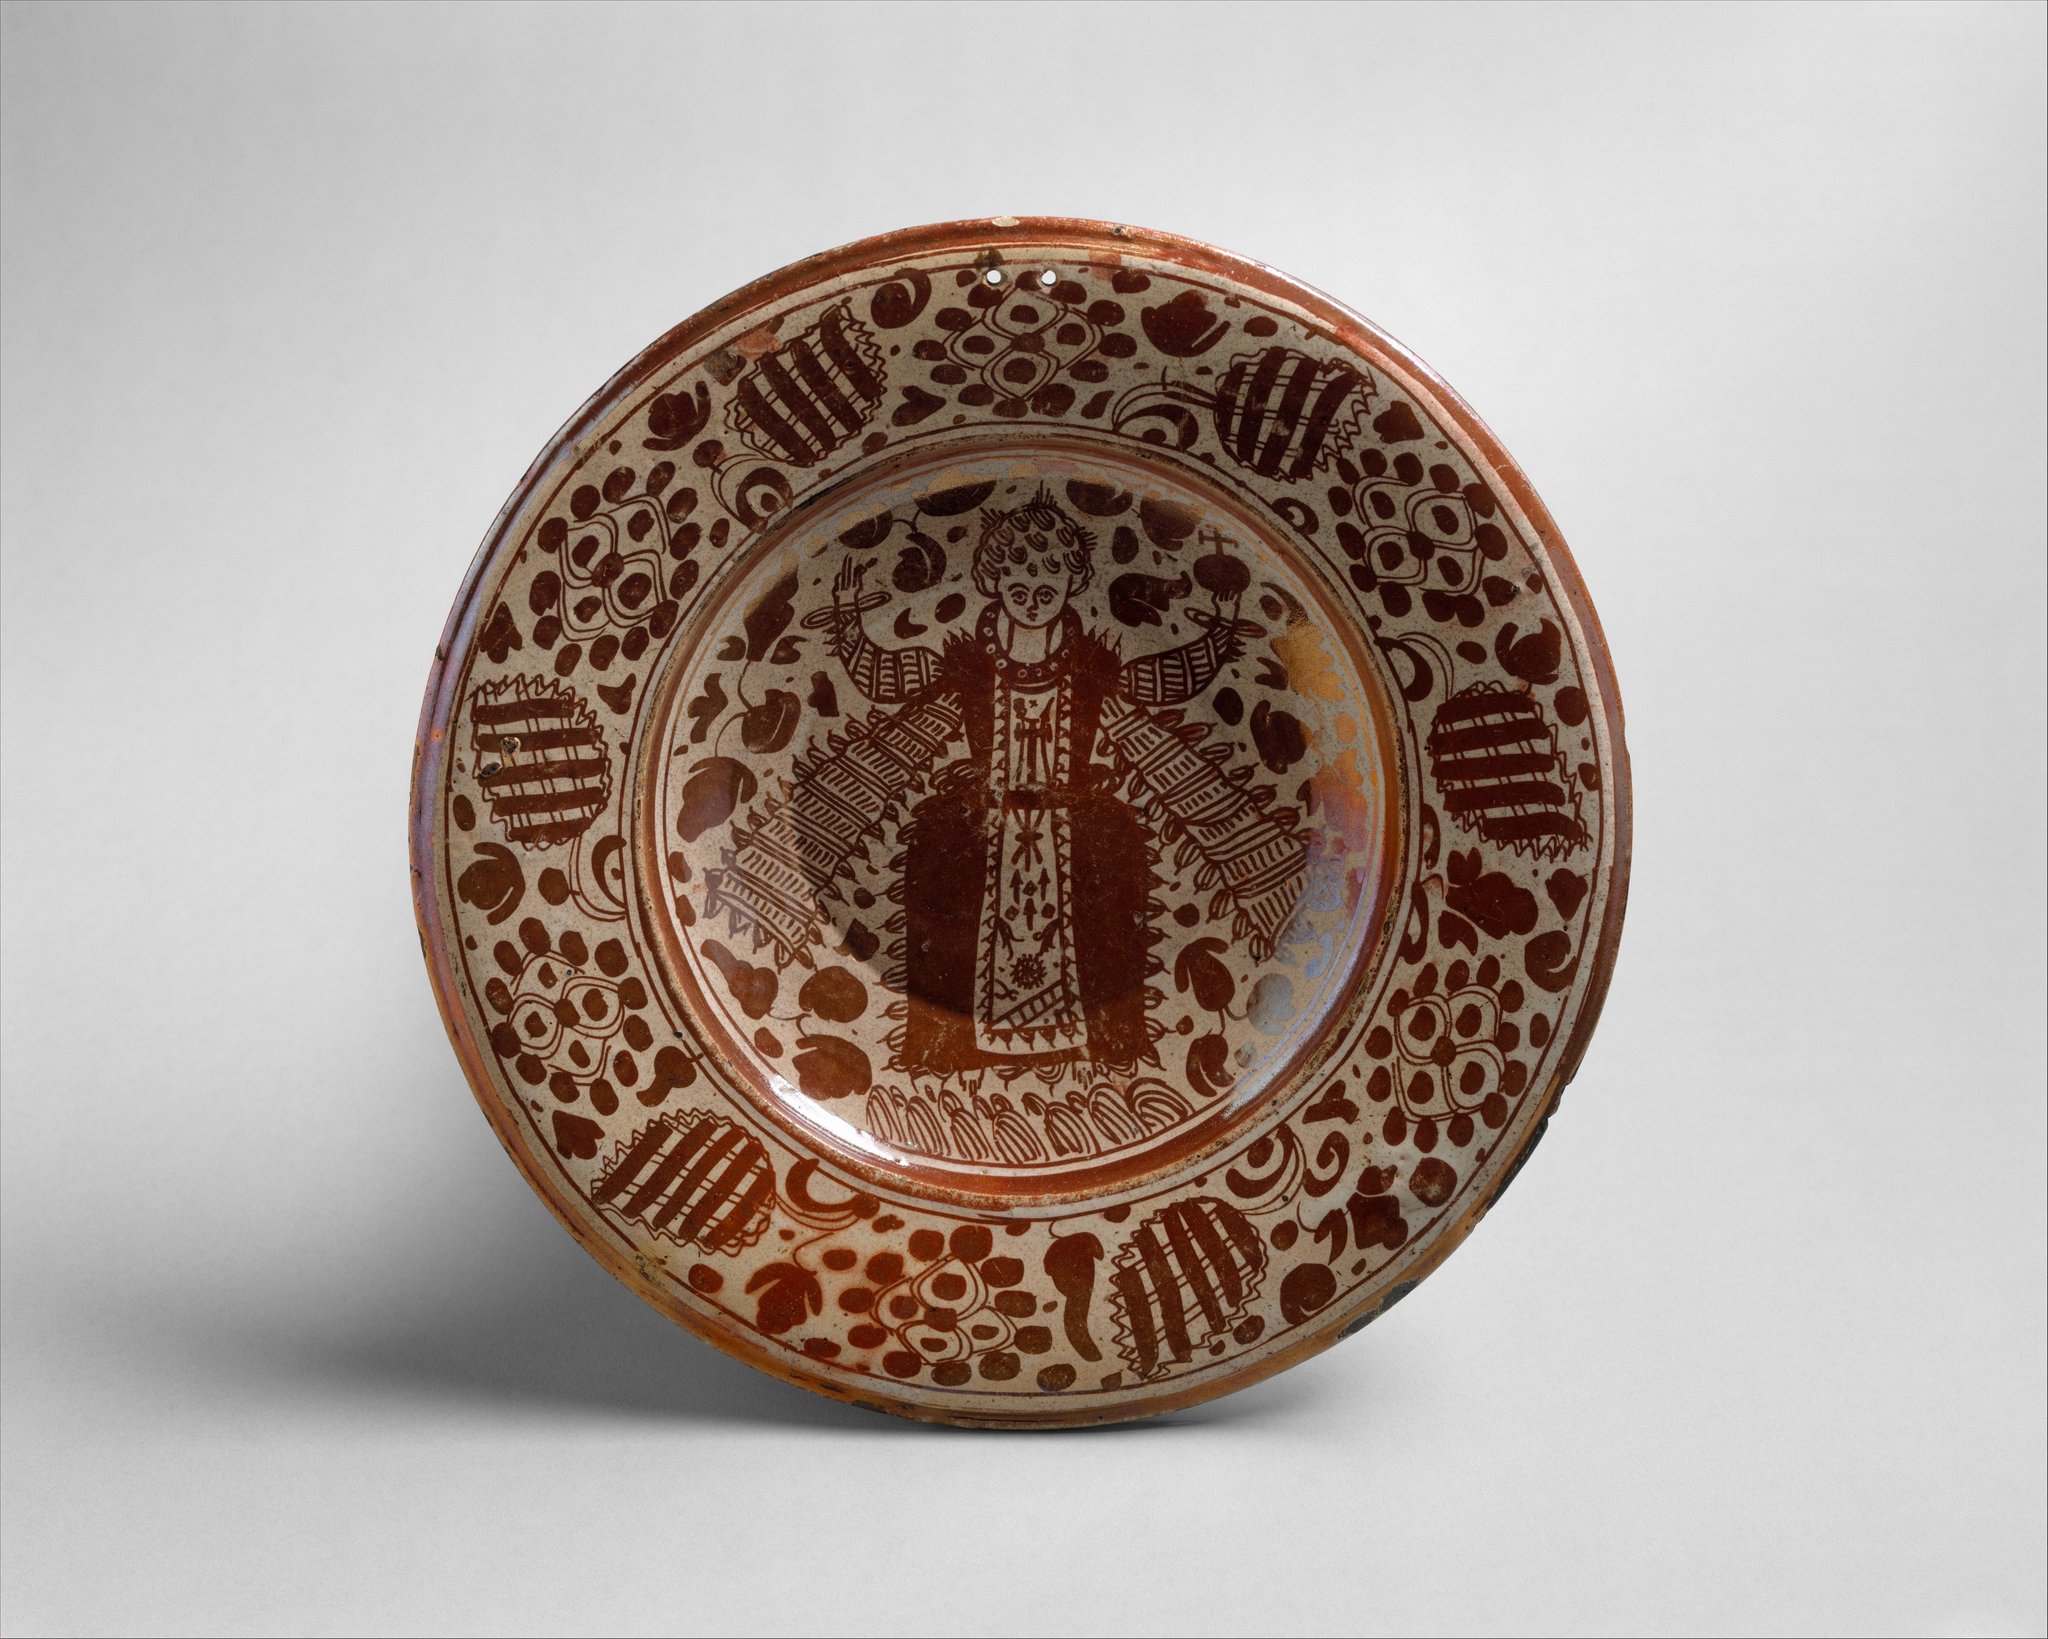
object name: dish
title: Dish with the Christ child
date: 1601-1633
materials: earthenware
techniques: luster painting, glazing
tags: christ